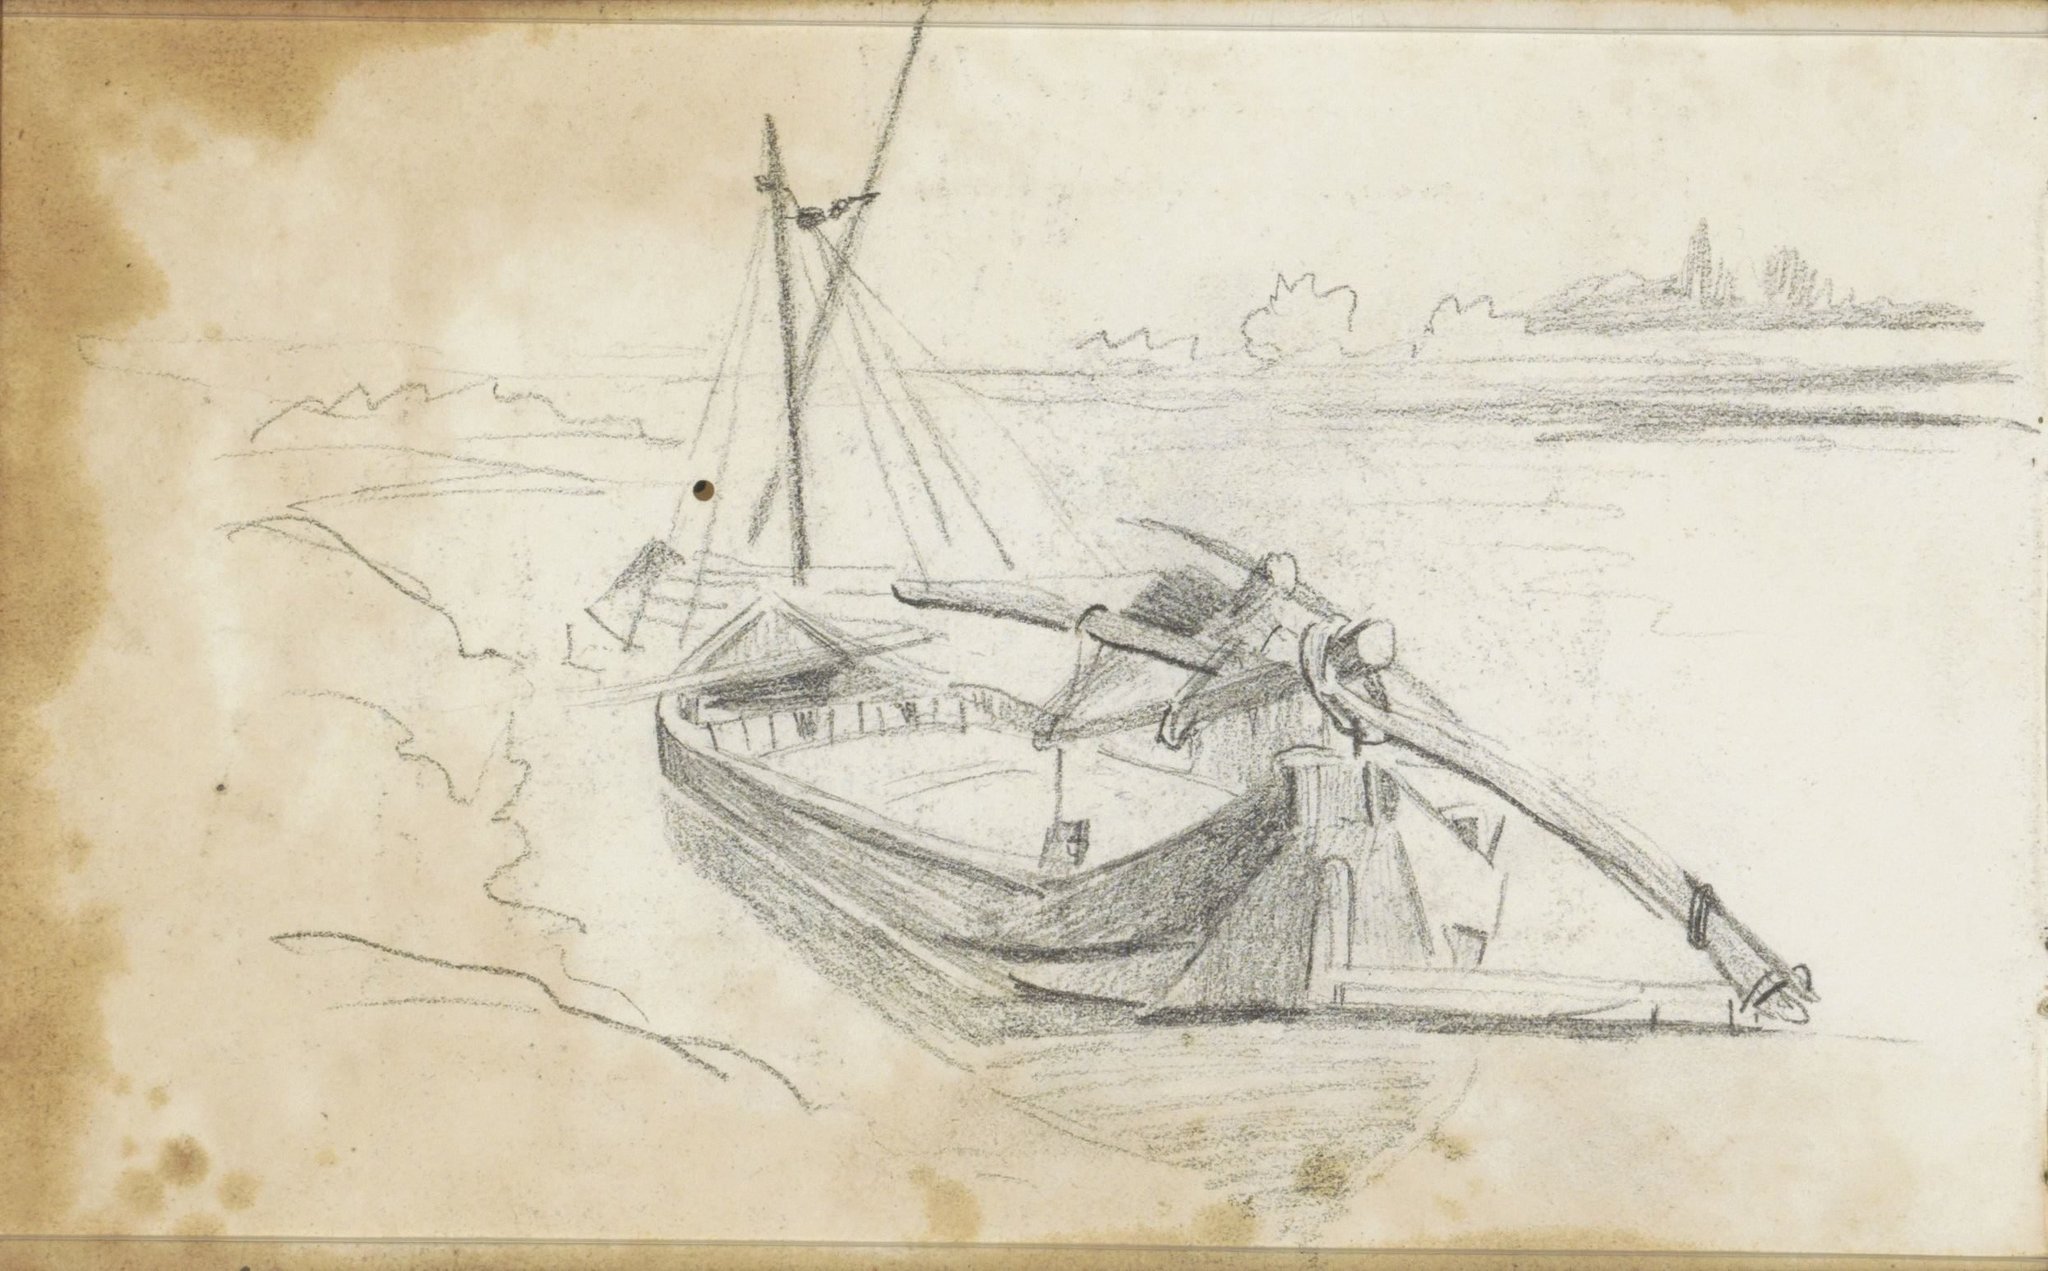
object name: sketchbook leaf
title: Houten roeiboot aan de oever van een rivier of meer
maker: johannes tavenraat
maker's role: draughtsman, painter, print maker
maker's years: 1809-1881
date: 1840-1841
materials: paper, pencil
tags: landscapes with waters, waterscapes, seascapes (in the temperate zone), rowing-boat, canoe, etc.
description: Blad 1 verso uit een schetsboek met 41 bladen.